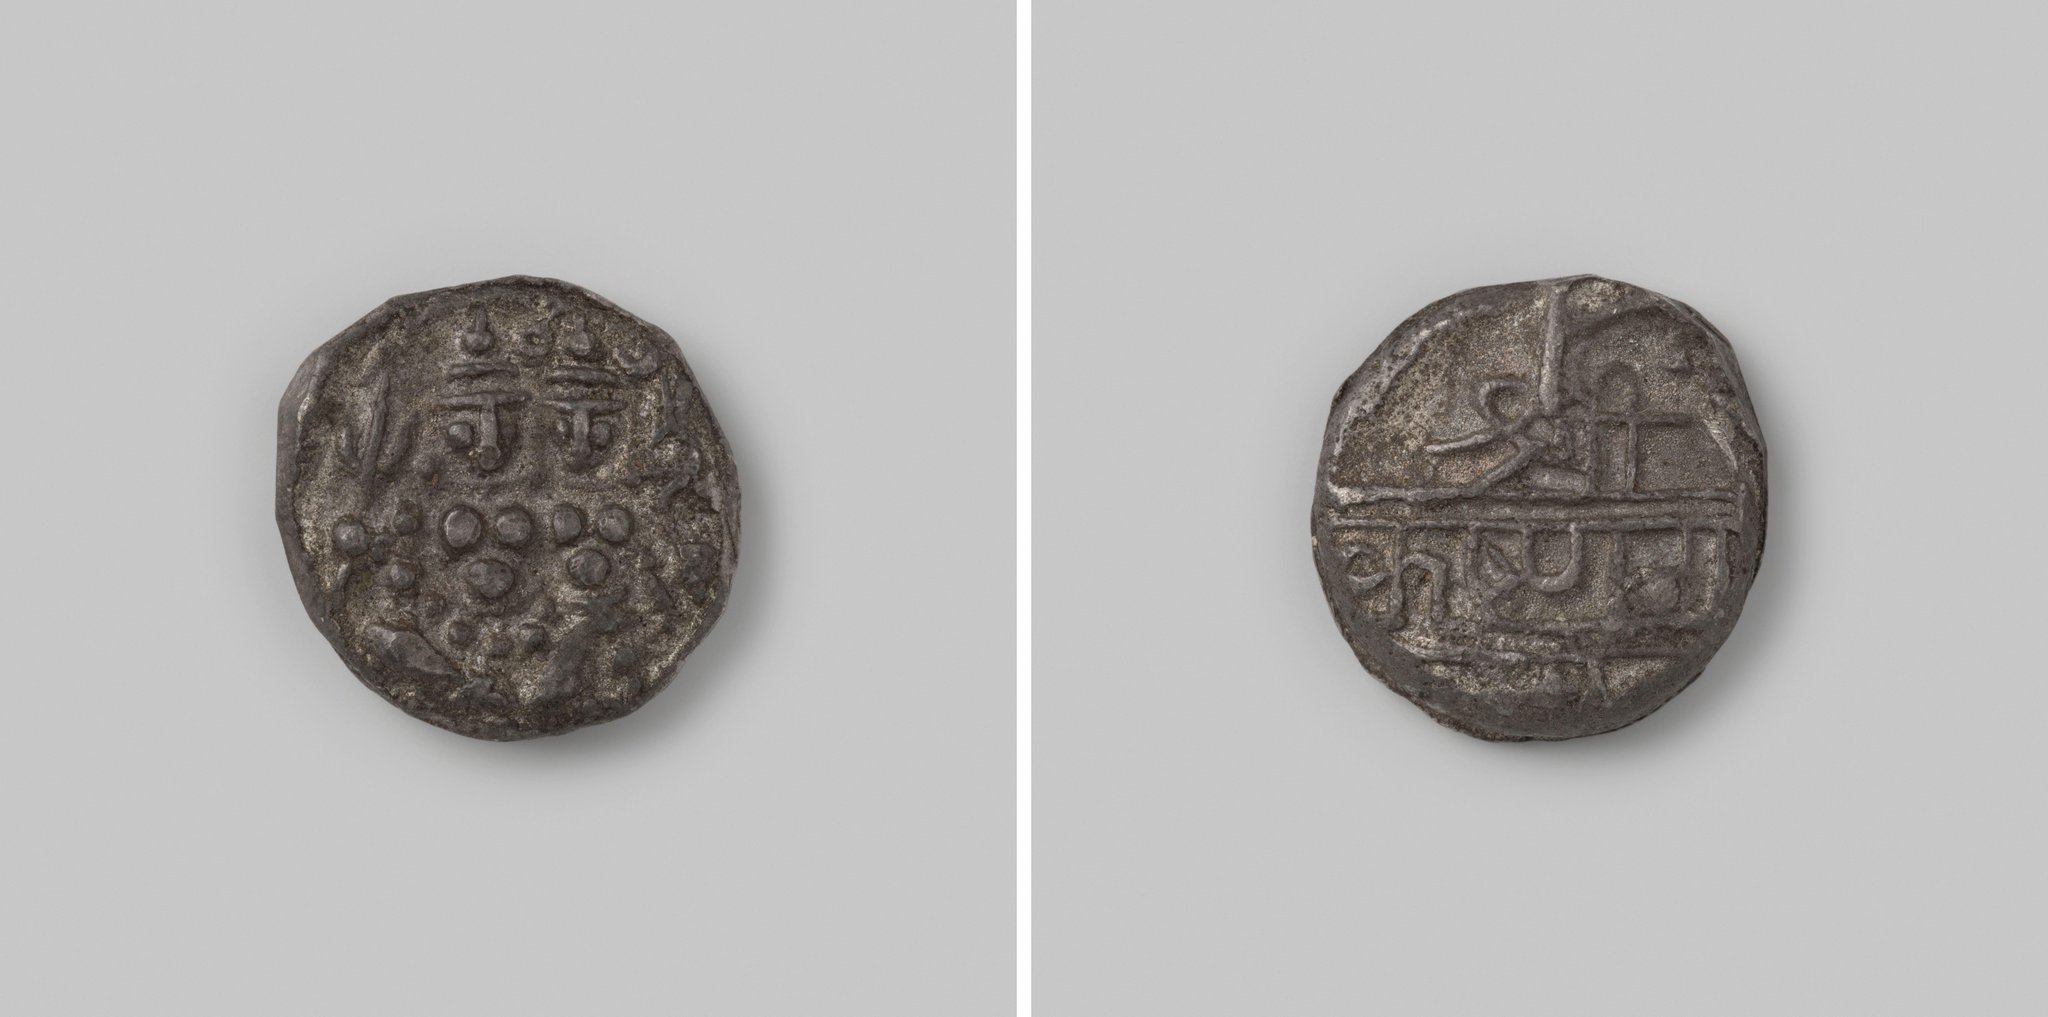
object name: coin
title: Loden afslag van een gouden pagoda uit Mysore in India van Sri Krishna Raya Wodeyar, 1799-1868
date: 1799-1868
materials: lead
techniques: striking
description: Afslag in lood van een gouden munt. Voorzijde: op een troon gezeten Siva met in zijn rechterhand een drietand en met op zijn linkerbeen gezeten zijn vrouw Parvati. Keerzijde: in Nagari-schrift in drie regels de naam van de vorst.